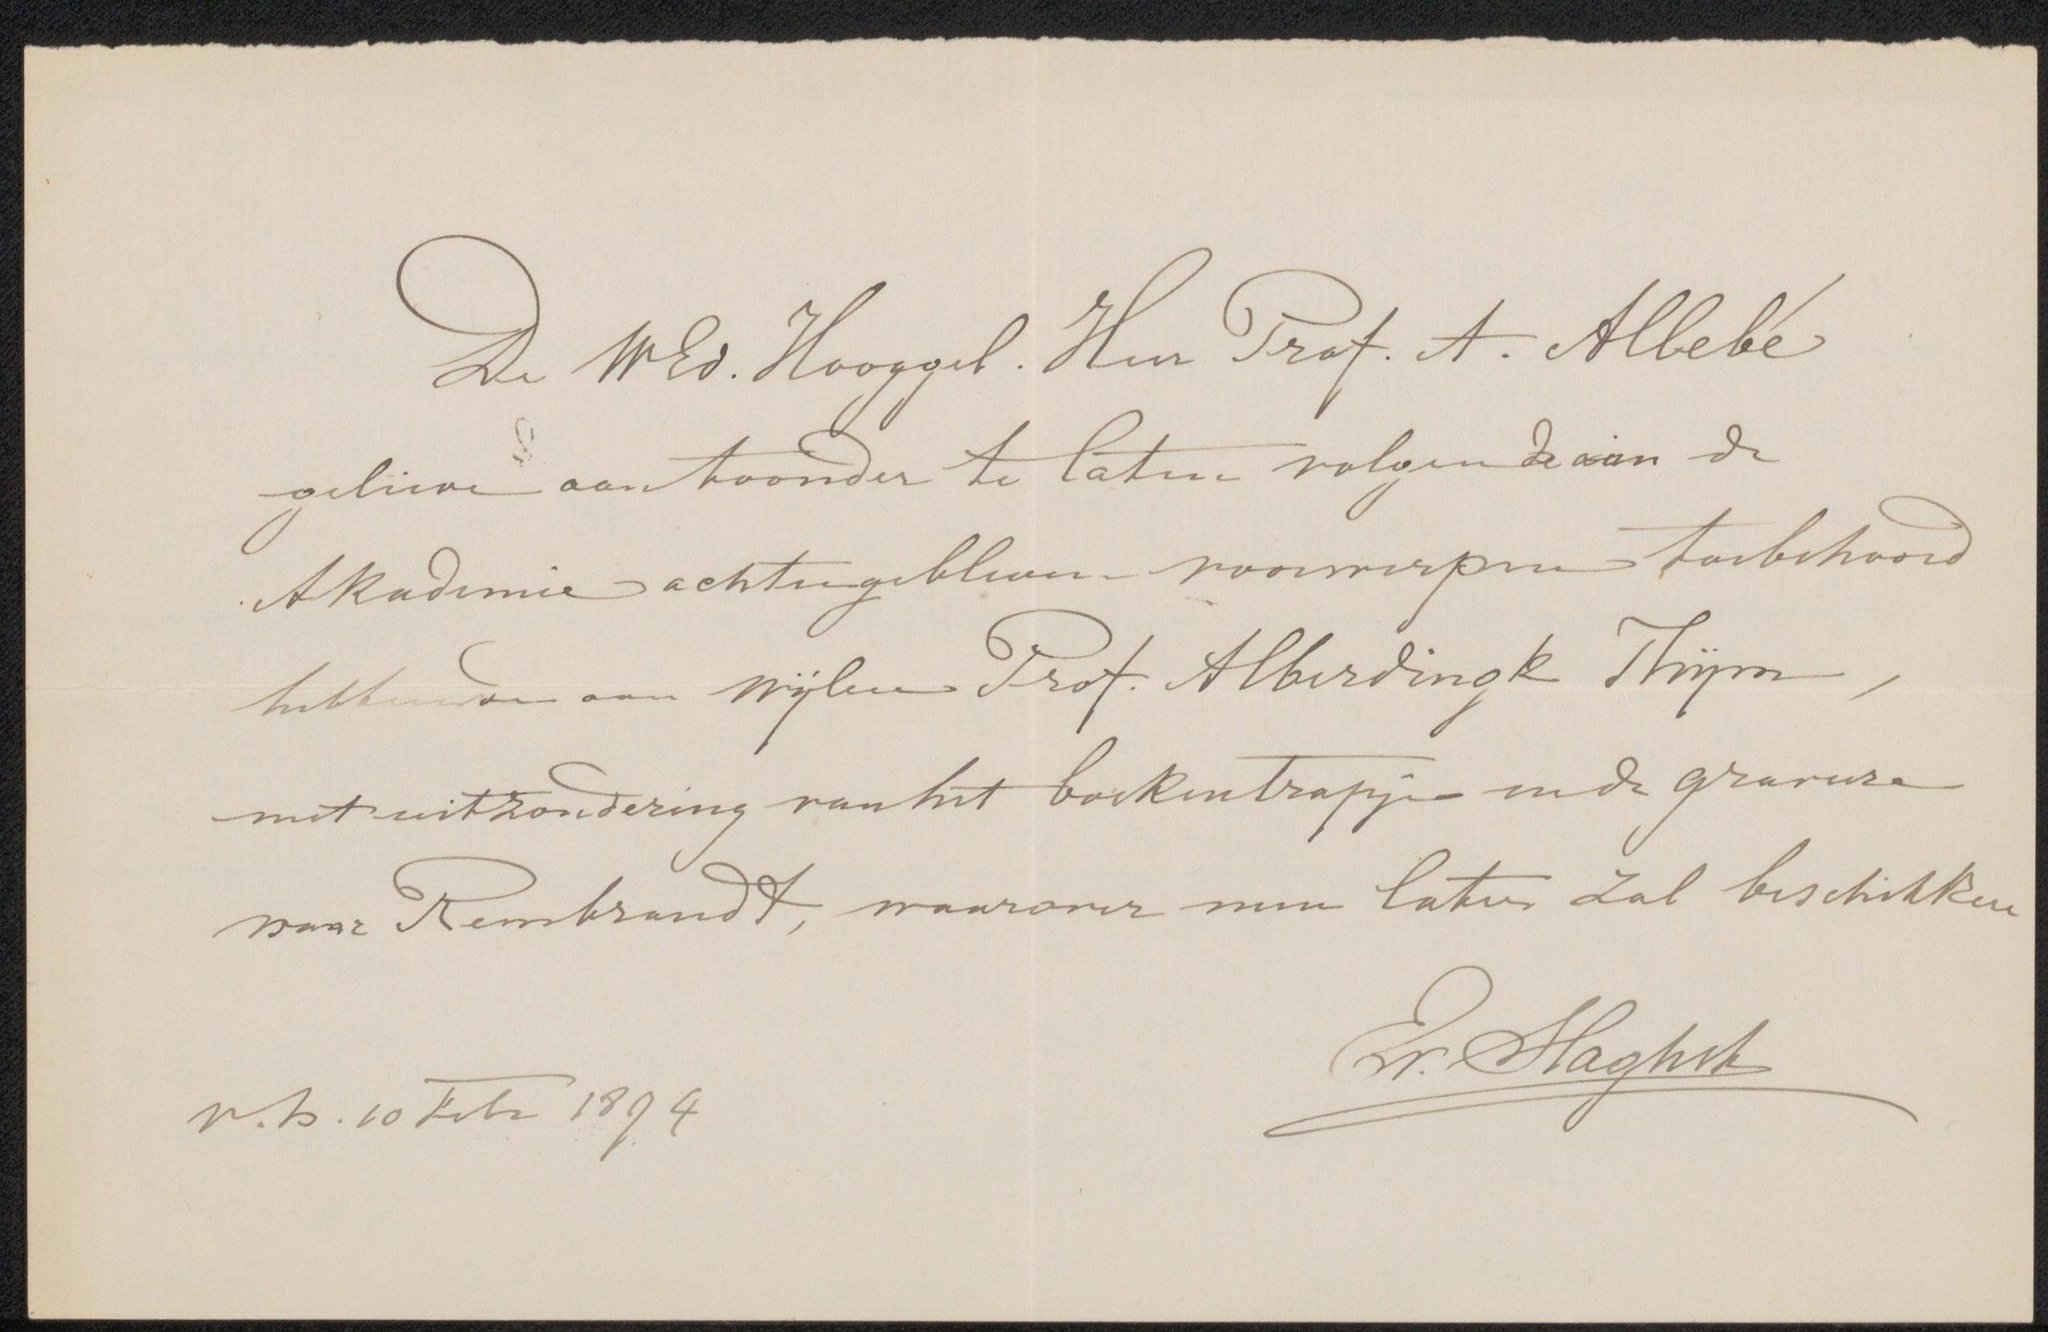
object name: letter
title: Brief aan August Allebé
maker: evert slaghek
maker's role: print maker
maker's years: 1827-1906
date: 1894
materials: ink, paper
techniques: pen, writing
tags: amsterdam, print maker, draughtsman, august allebé, leiden, rembrandt van rijn, painter, publisher, josephus albertus alberdingk thijm, the graphic arts